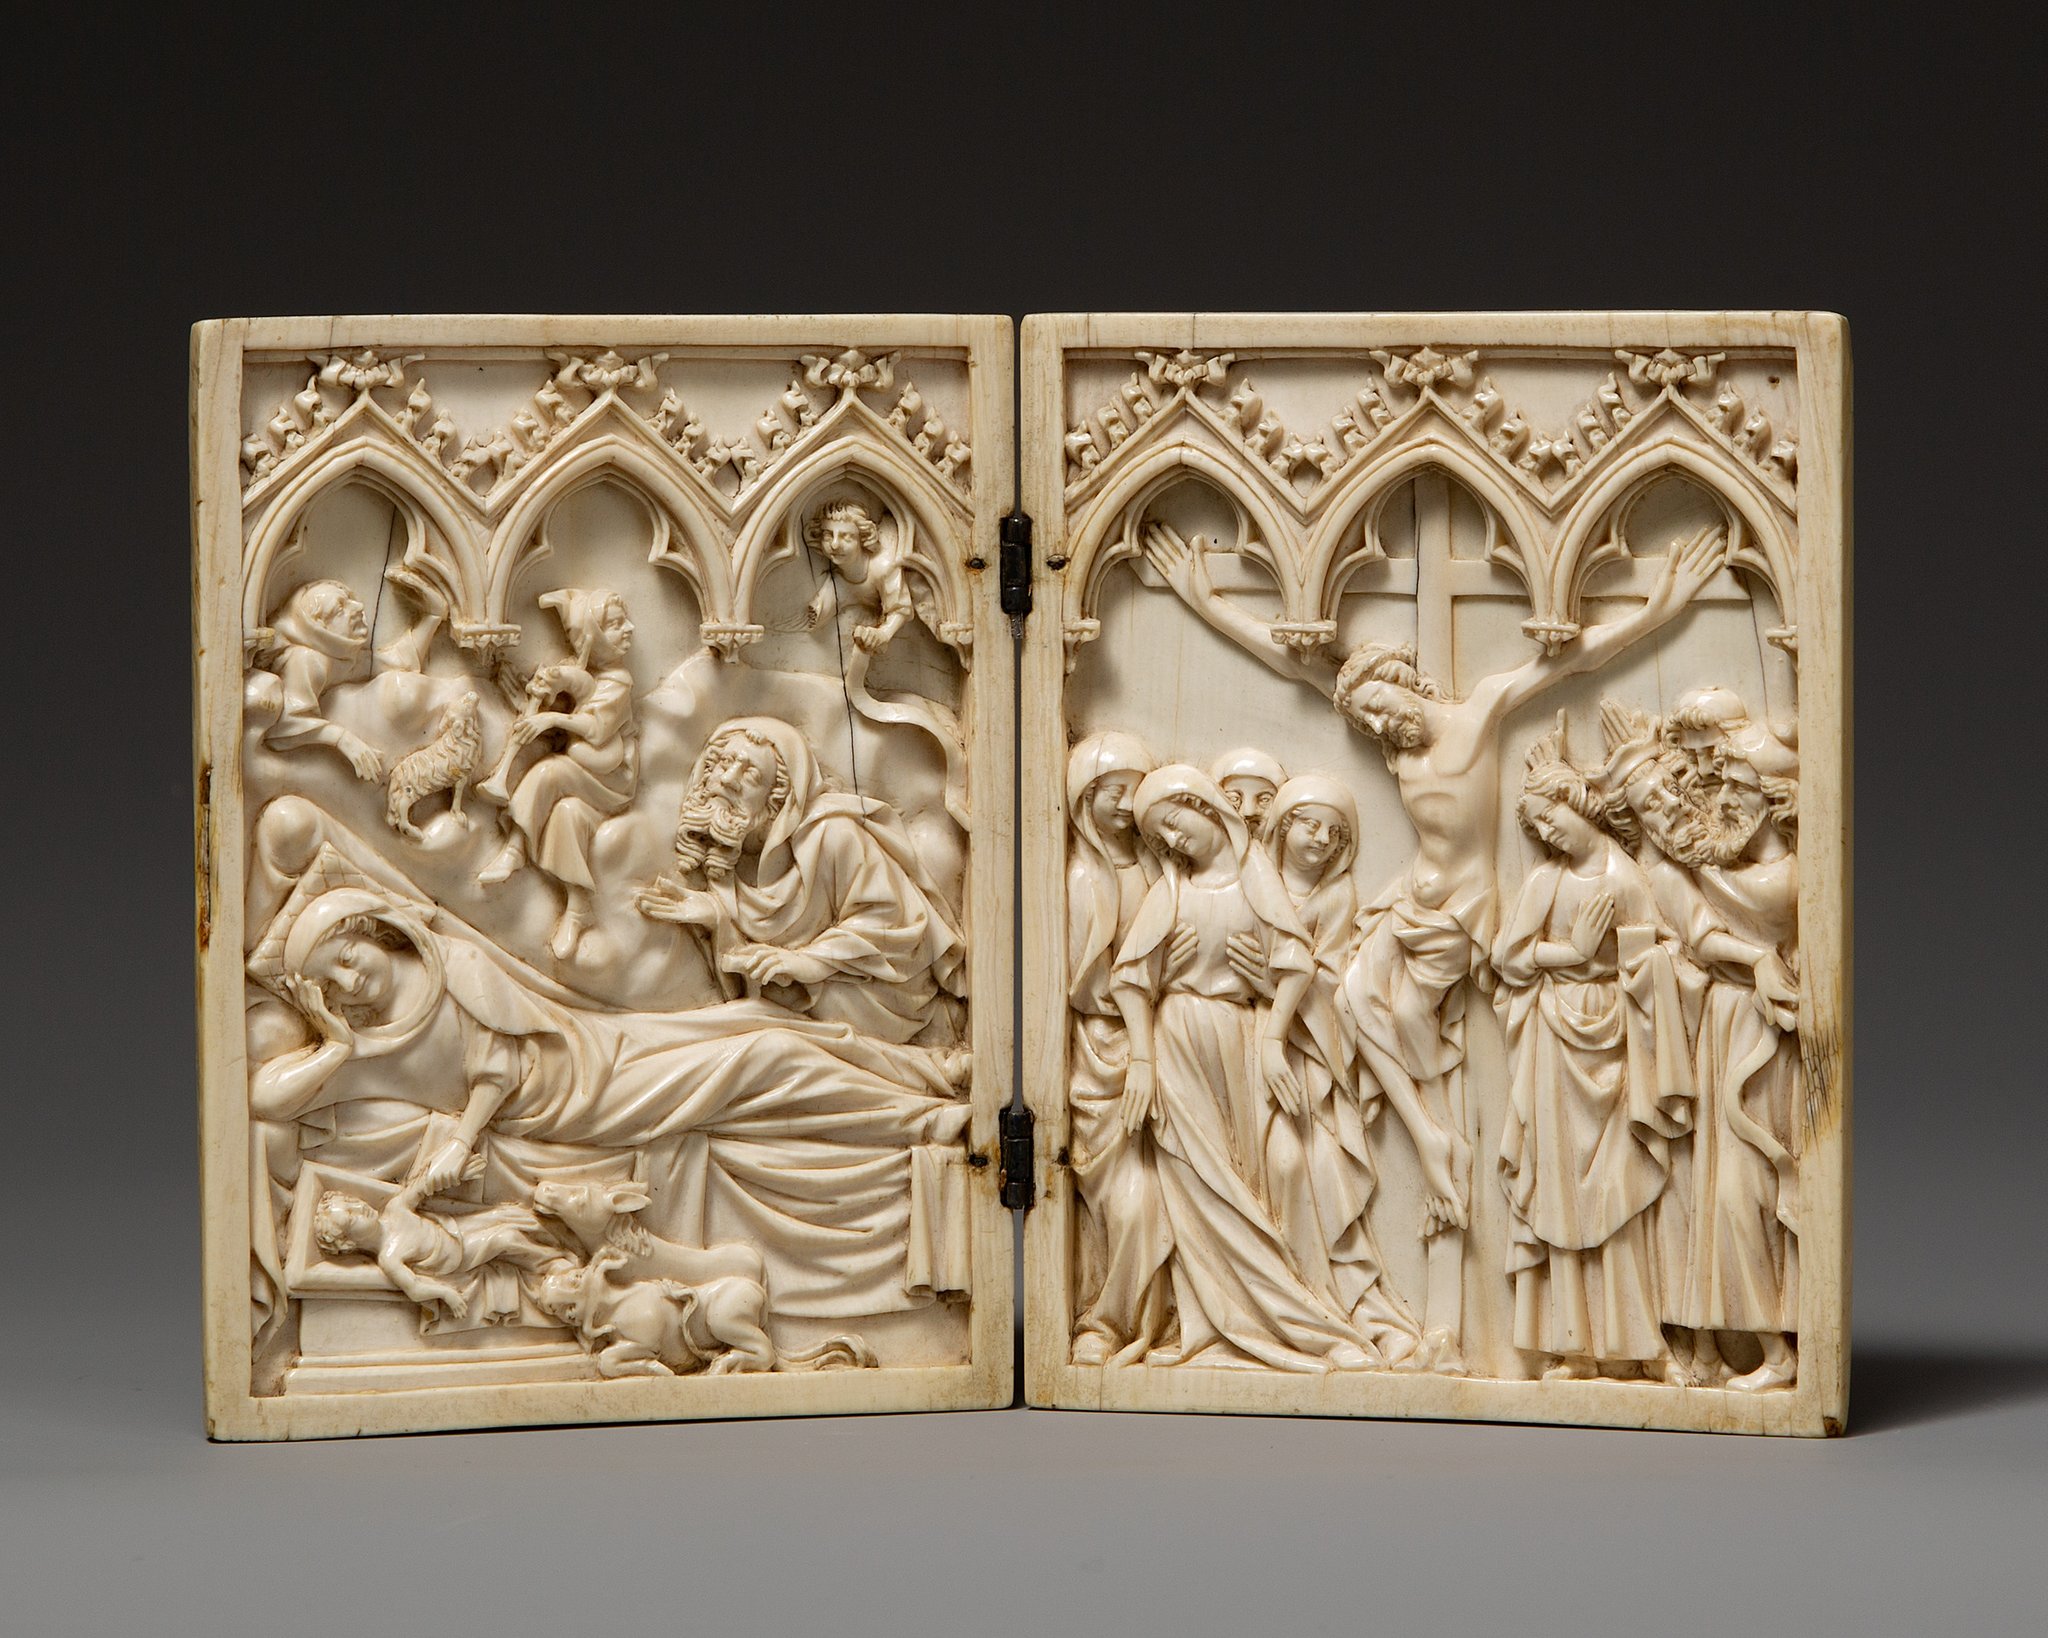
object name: diptych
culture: french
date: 1301-1400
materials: ivory, metal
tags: donkeys,angels,madonna and child,crucifixion,nativity,saints